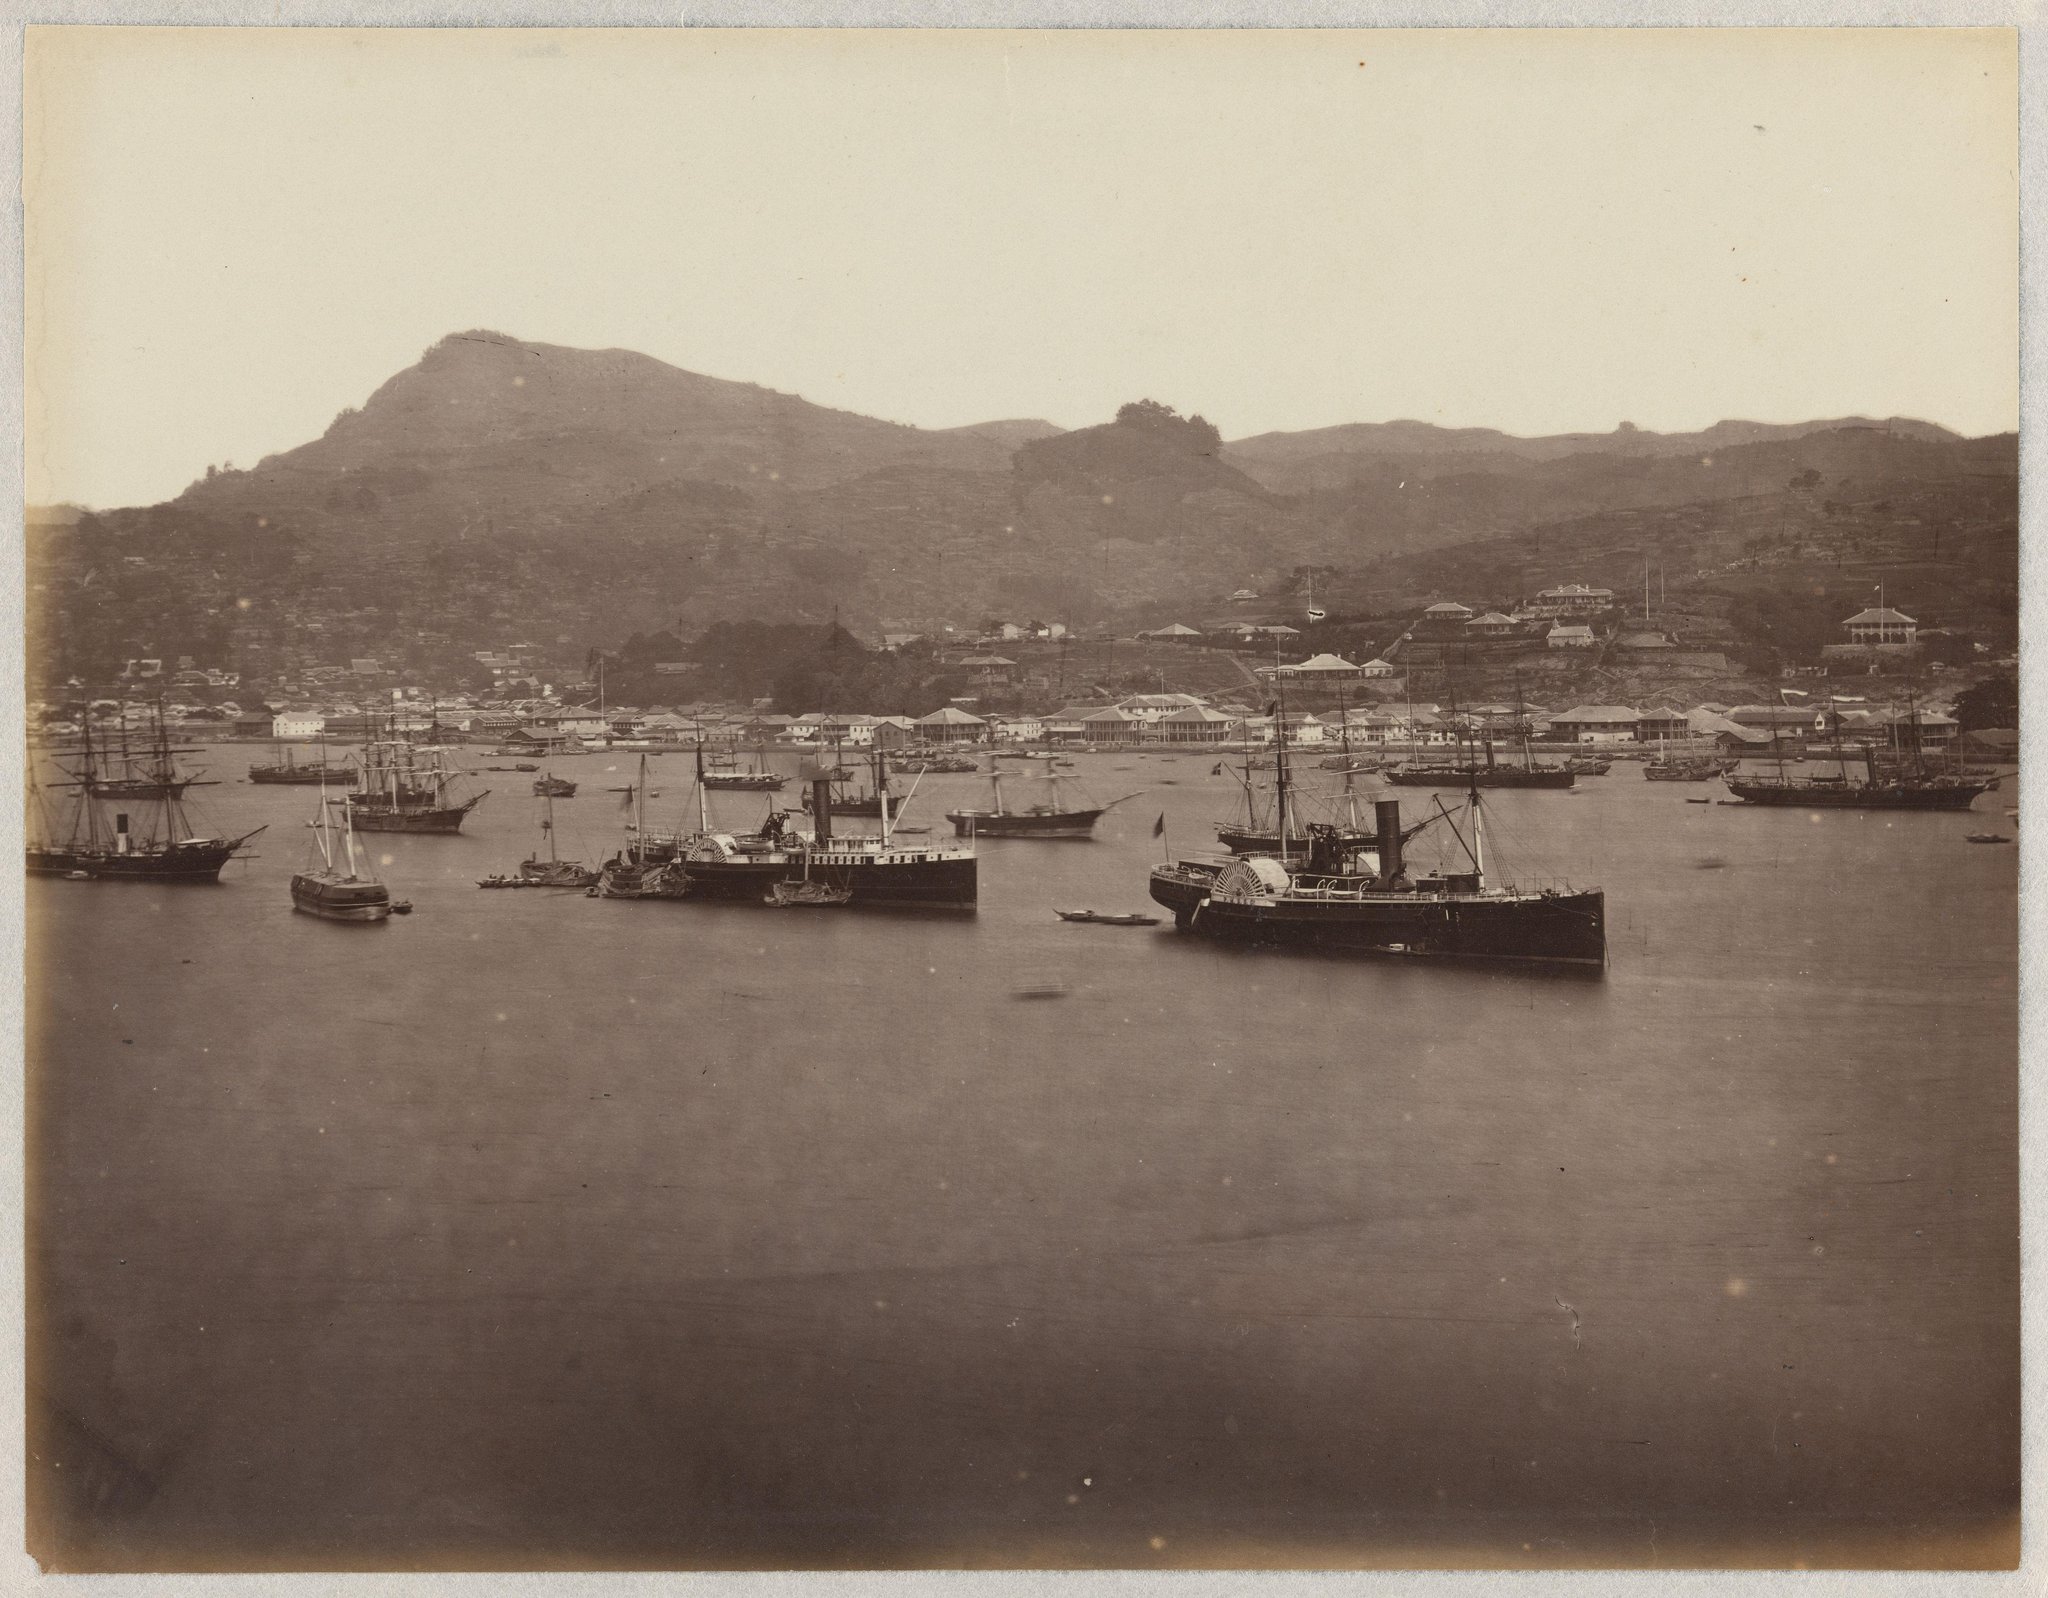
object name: photograph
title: Haven van Nagasaki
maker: Anonymous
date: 1865-1875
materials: paper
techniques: albumen print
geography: japan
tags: nagasaki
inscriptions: number: ‘N3’, number: ‘N3’